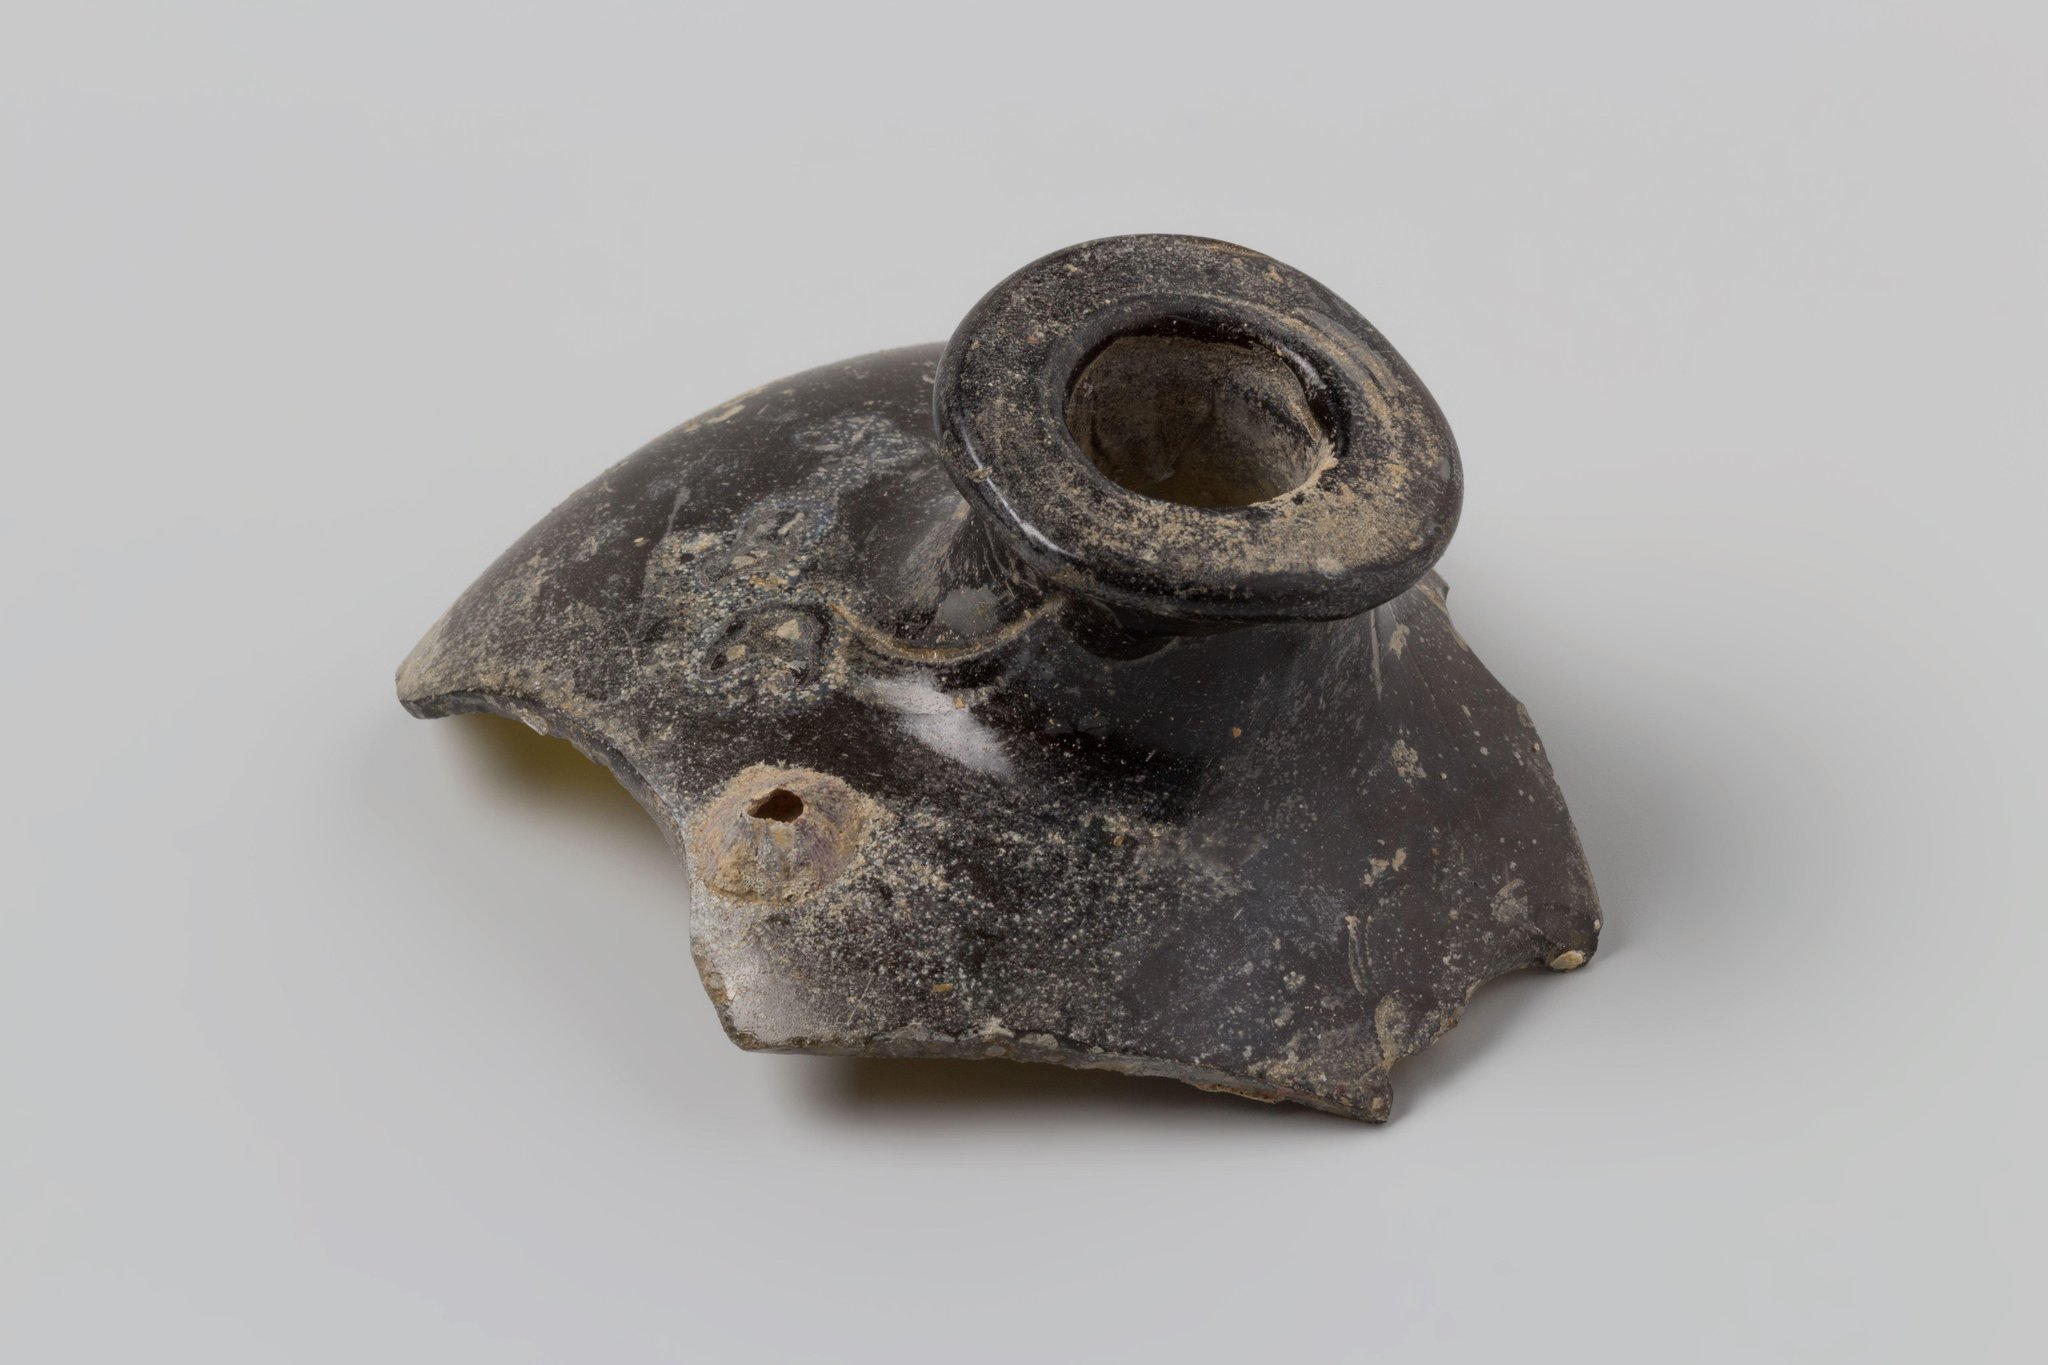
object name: sherd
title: Scherf van kistfles uit V.O.C.-schip de 'Witte Leeuw'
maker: Anonymous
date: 1613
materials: glass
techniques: green glass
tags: verenigde oostindische compagnie, sint-helena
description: Scherf van kistfles uit V.O.C.-schip de 'Witte Leeuw', flessenhals van groen glas met gedraaide lijnen en koraalachtige aanslag.